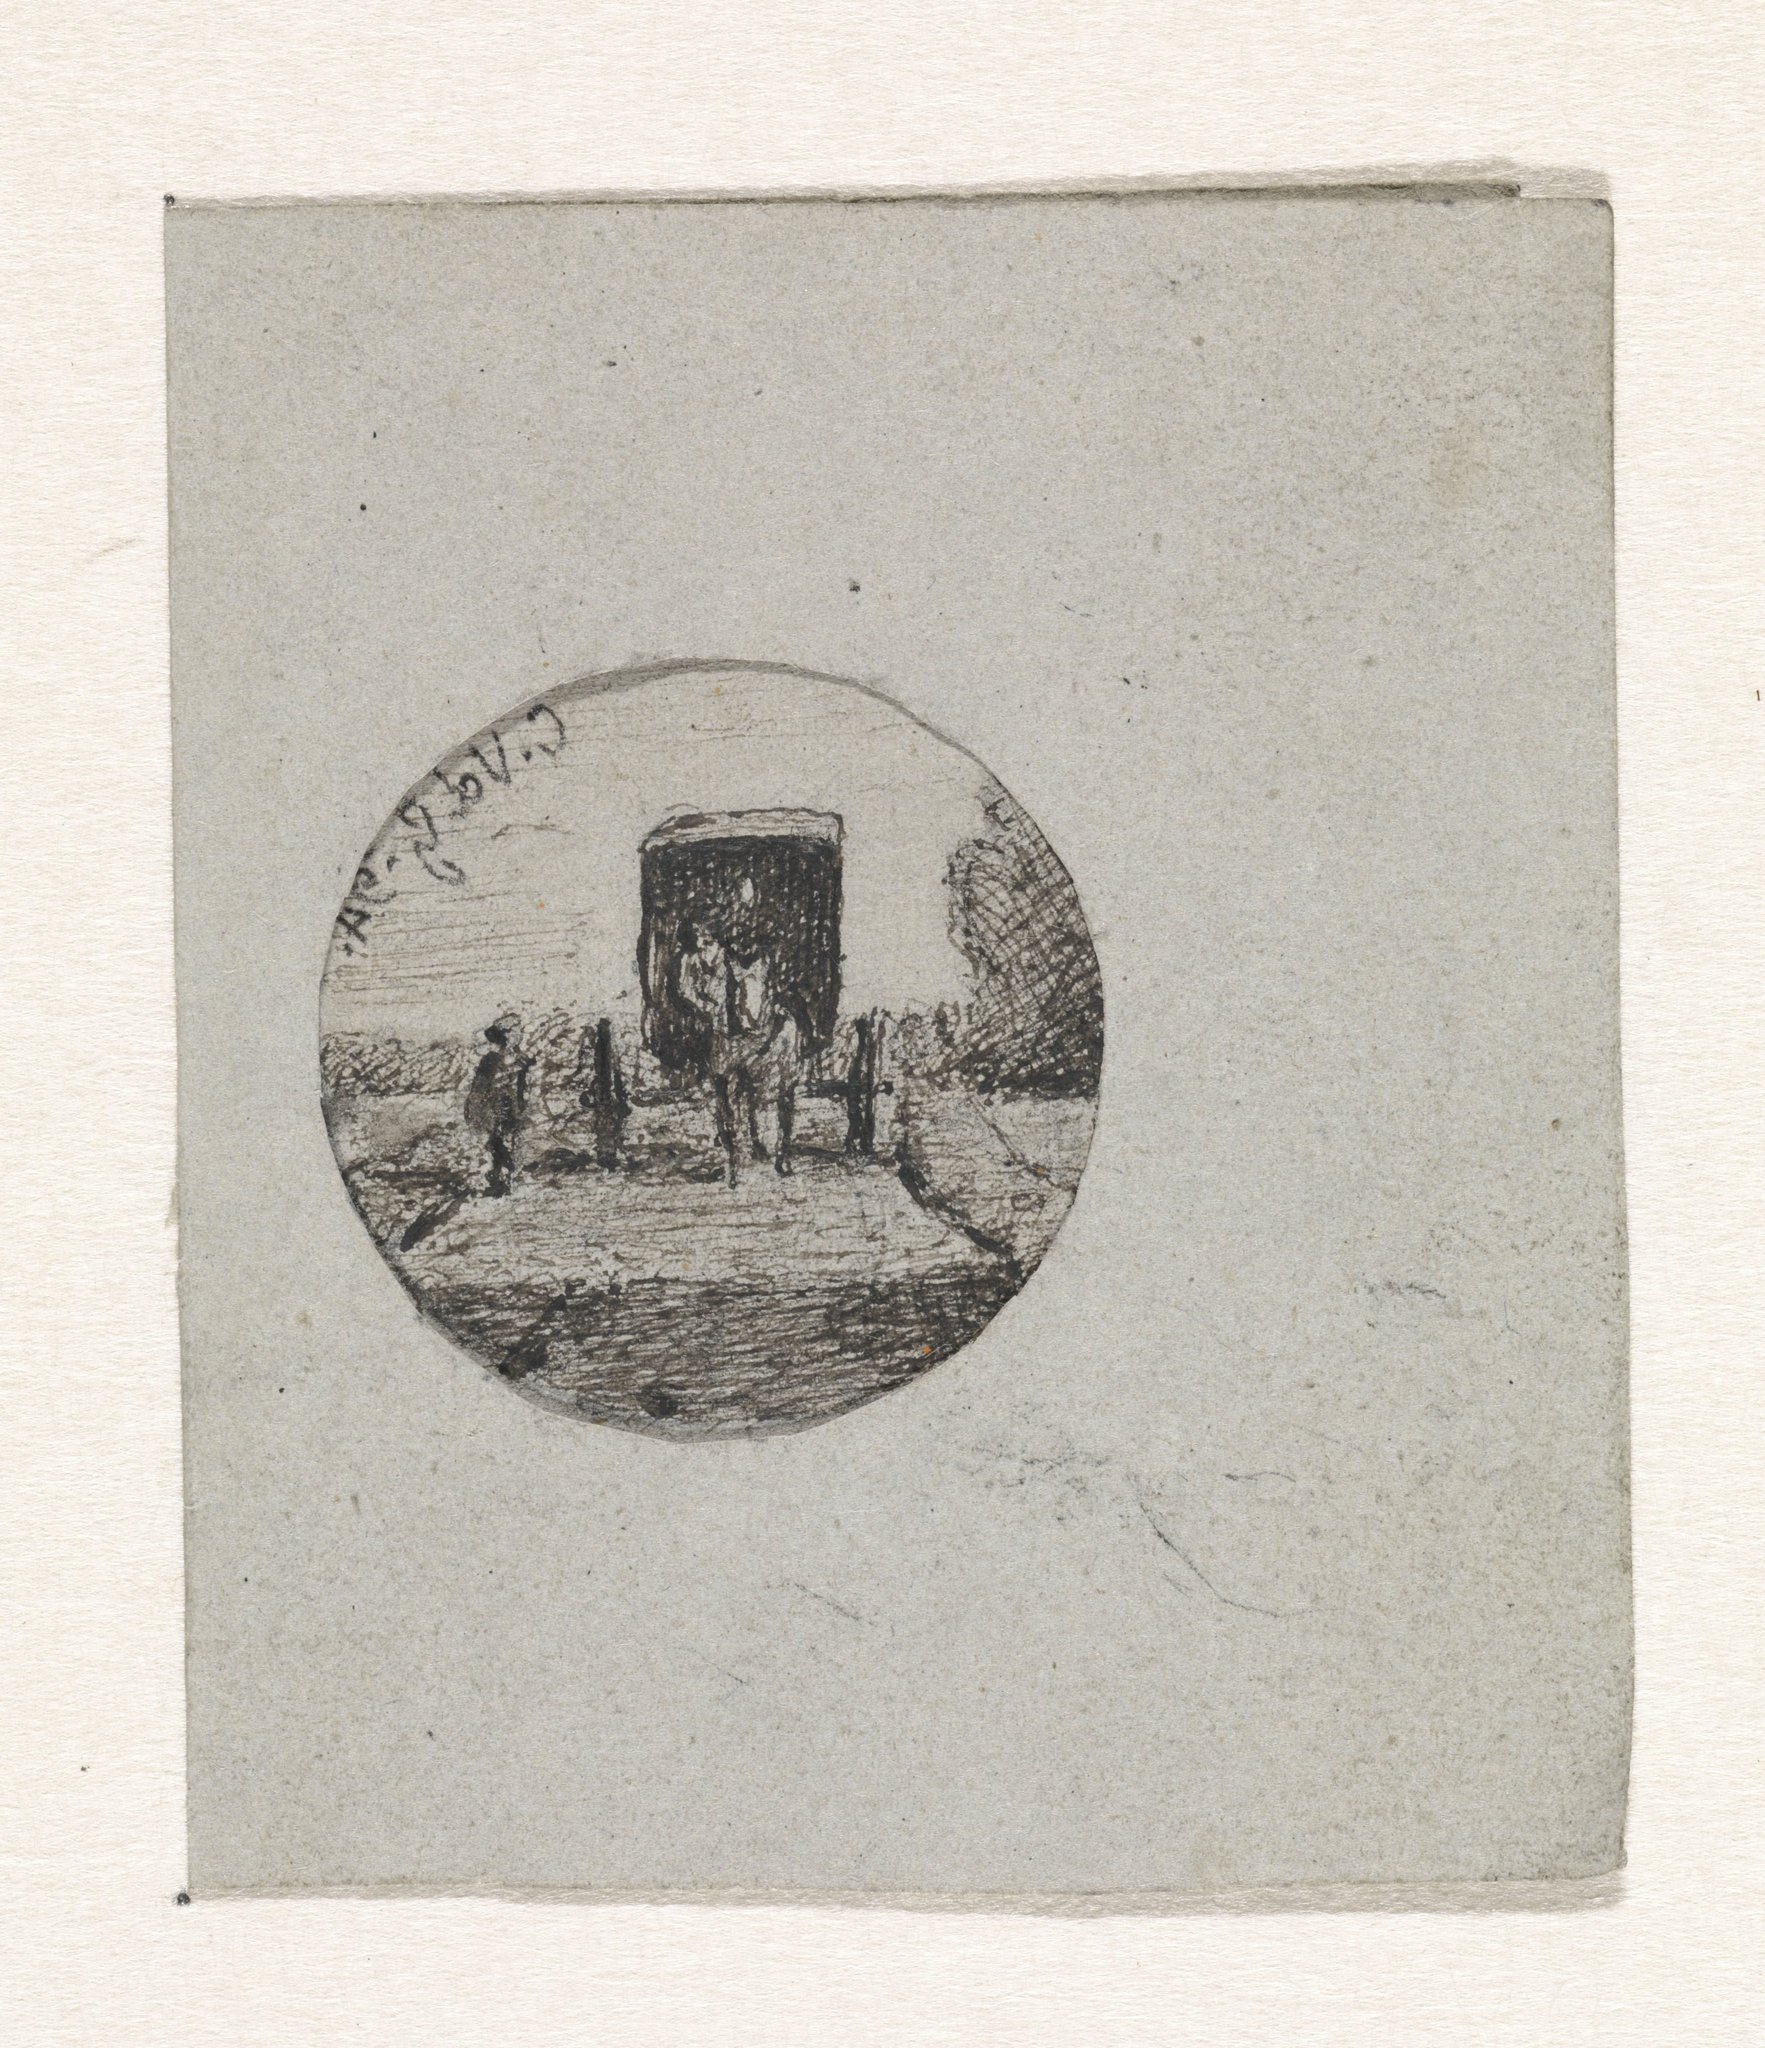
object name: drawing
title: Dokterskoetsje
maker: cornelis van der griendt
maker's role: draughtsman, painter, print maker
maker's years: 1827-1918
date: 1894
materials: ink, paper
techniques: pen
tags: four-wheeled vehicle drawn by one animal